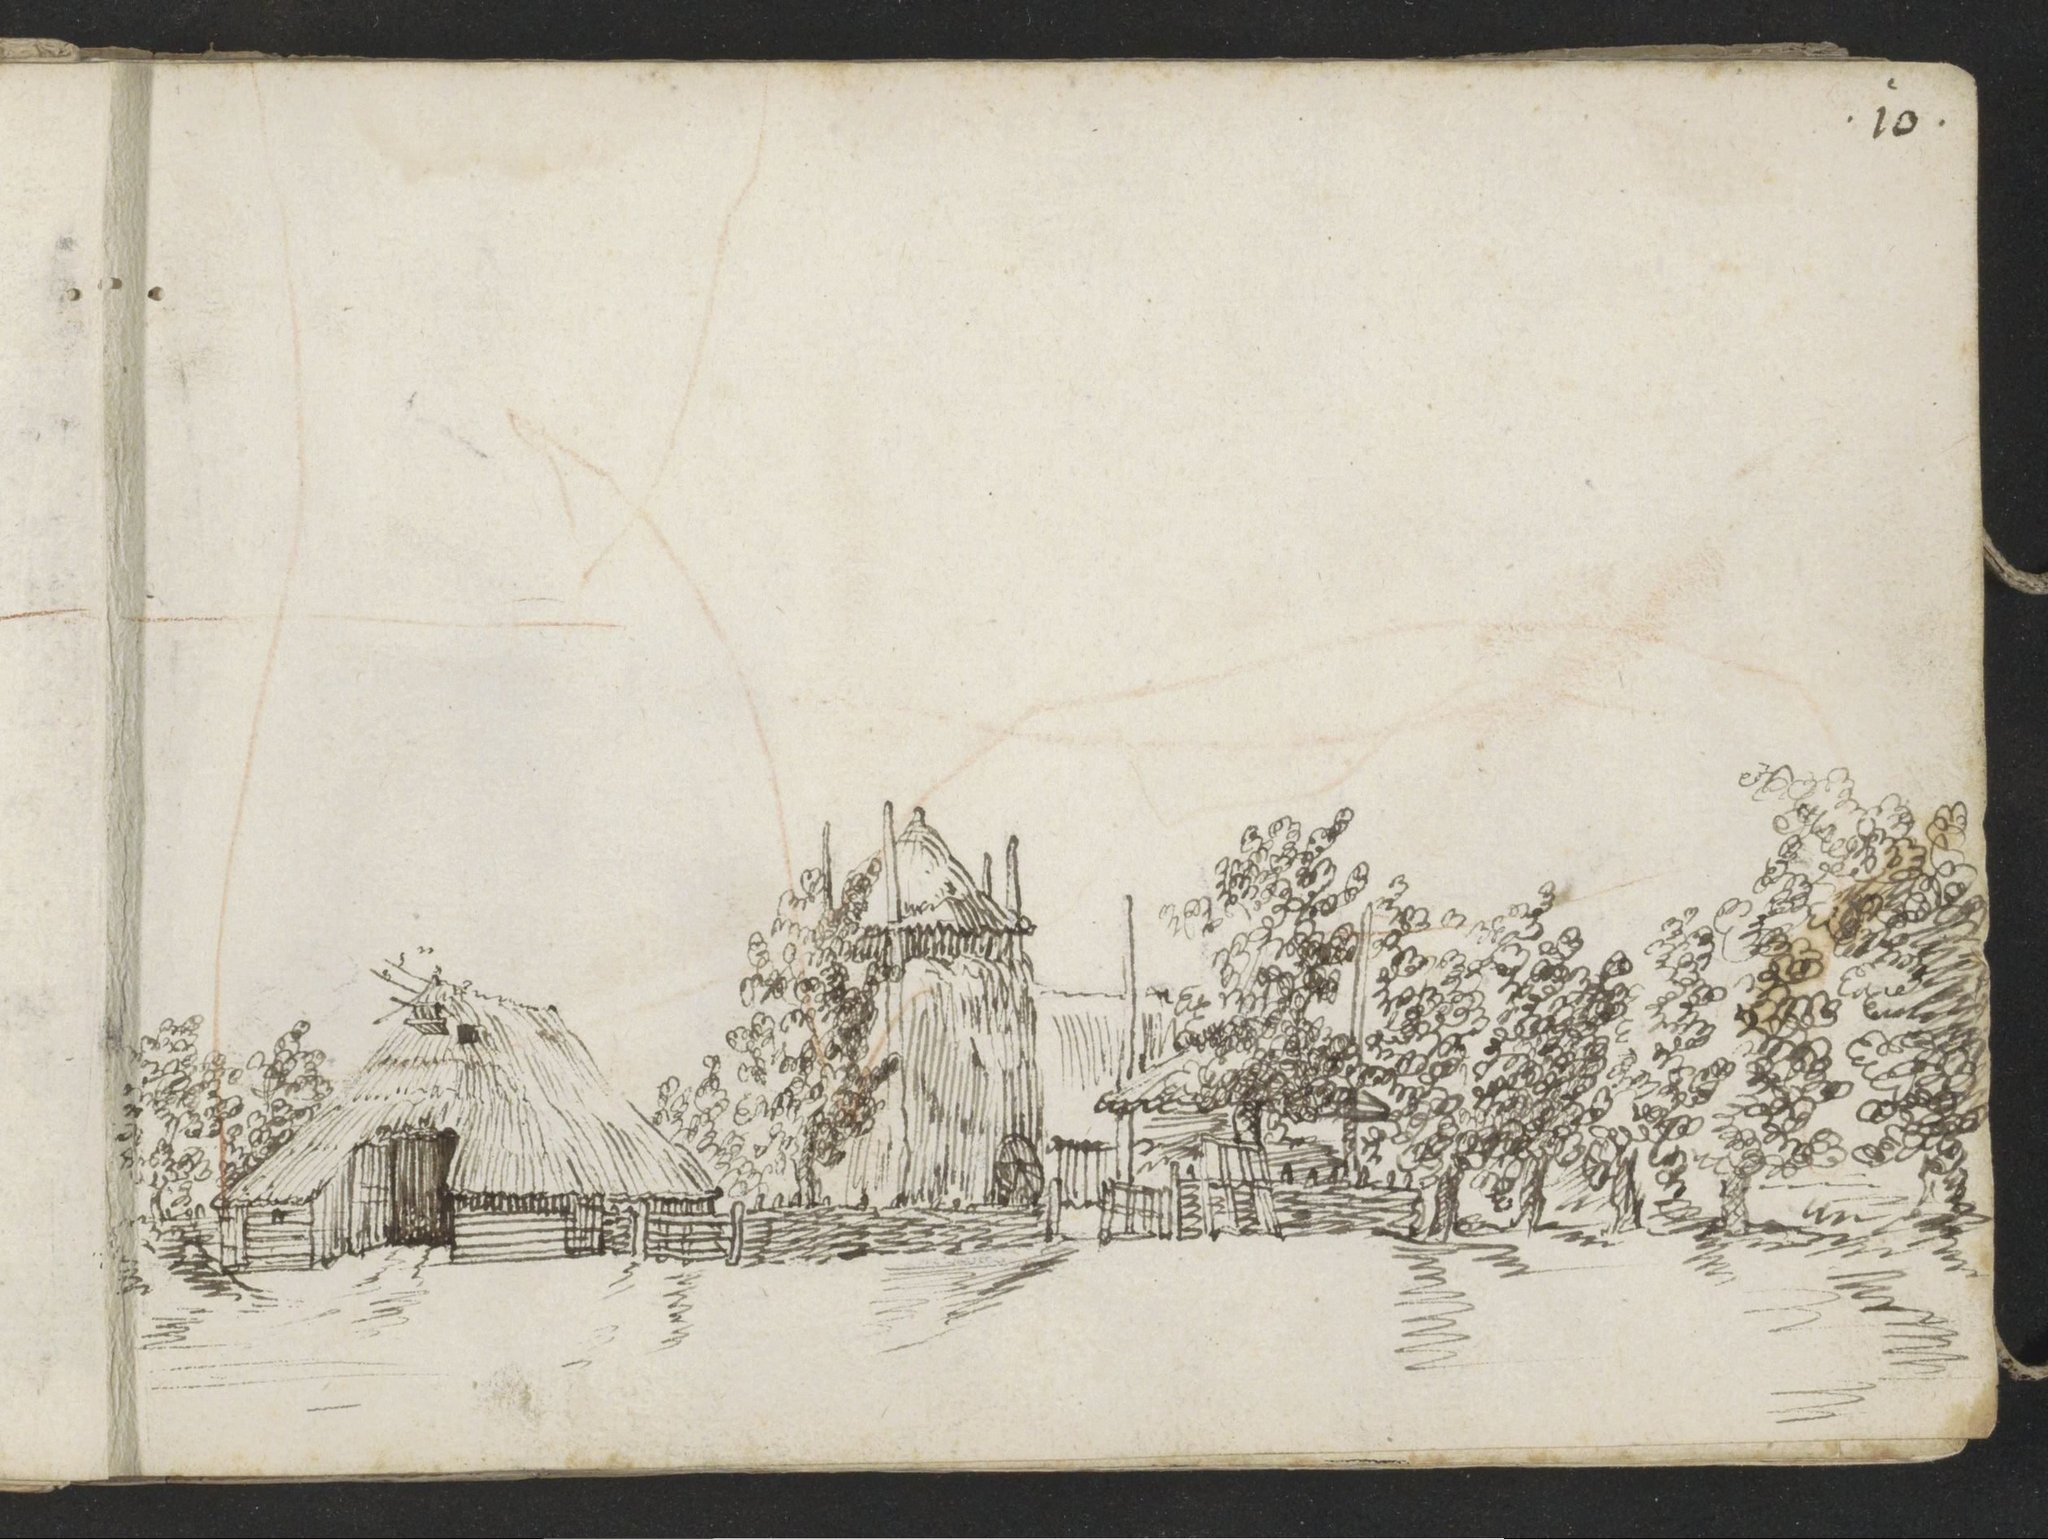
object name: sketchbook leaf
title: Boerderij met hooischuur en boomgaard buiten Zwolle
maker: gerard ter borch (ii)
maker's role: draughtsman, painter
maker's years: 1617-1681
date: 1631-1633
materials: chalk, ink, paper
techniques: pen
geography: zwolle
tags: hay-stack, farm (building)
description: Blad 10 recto uit een schetsboek met 55 bladen.